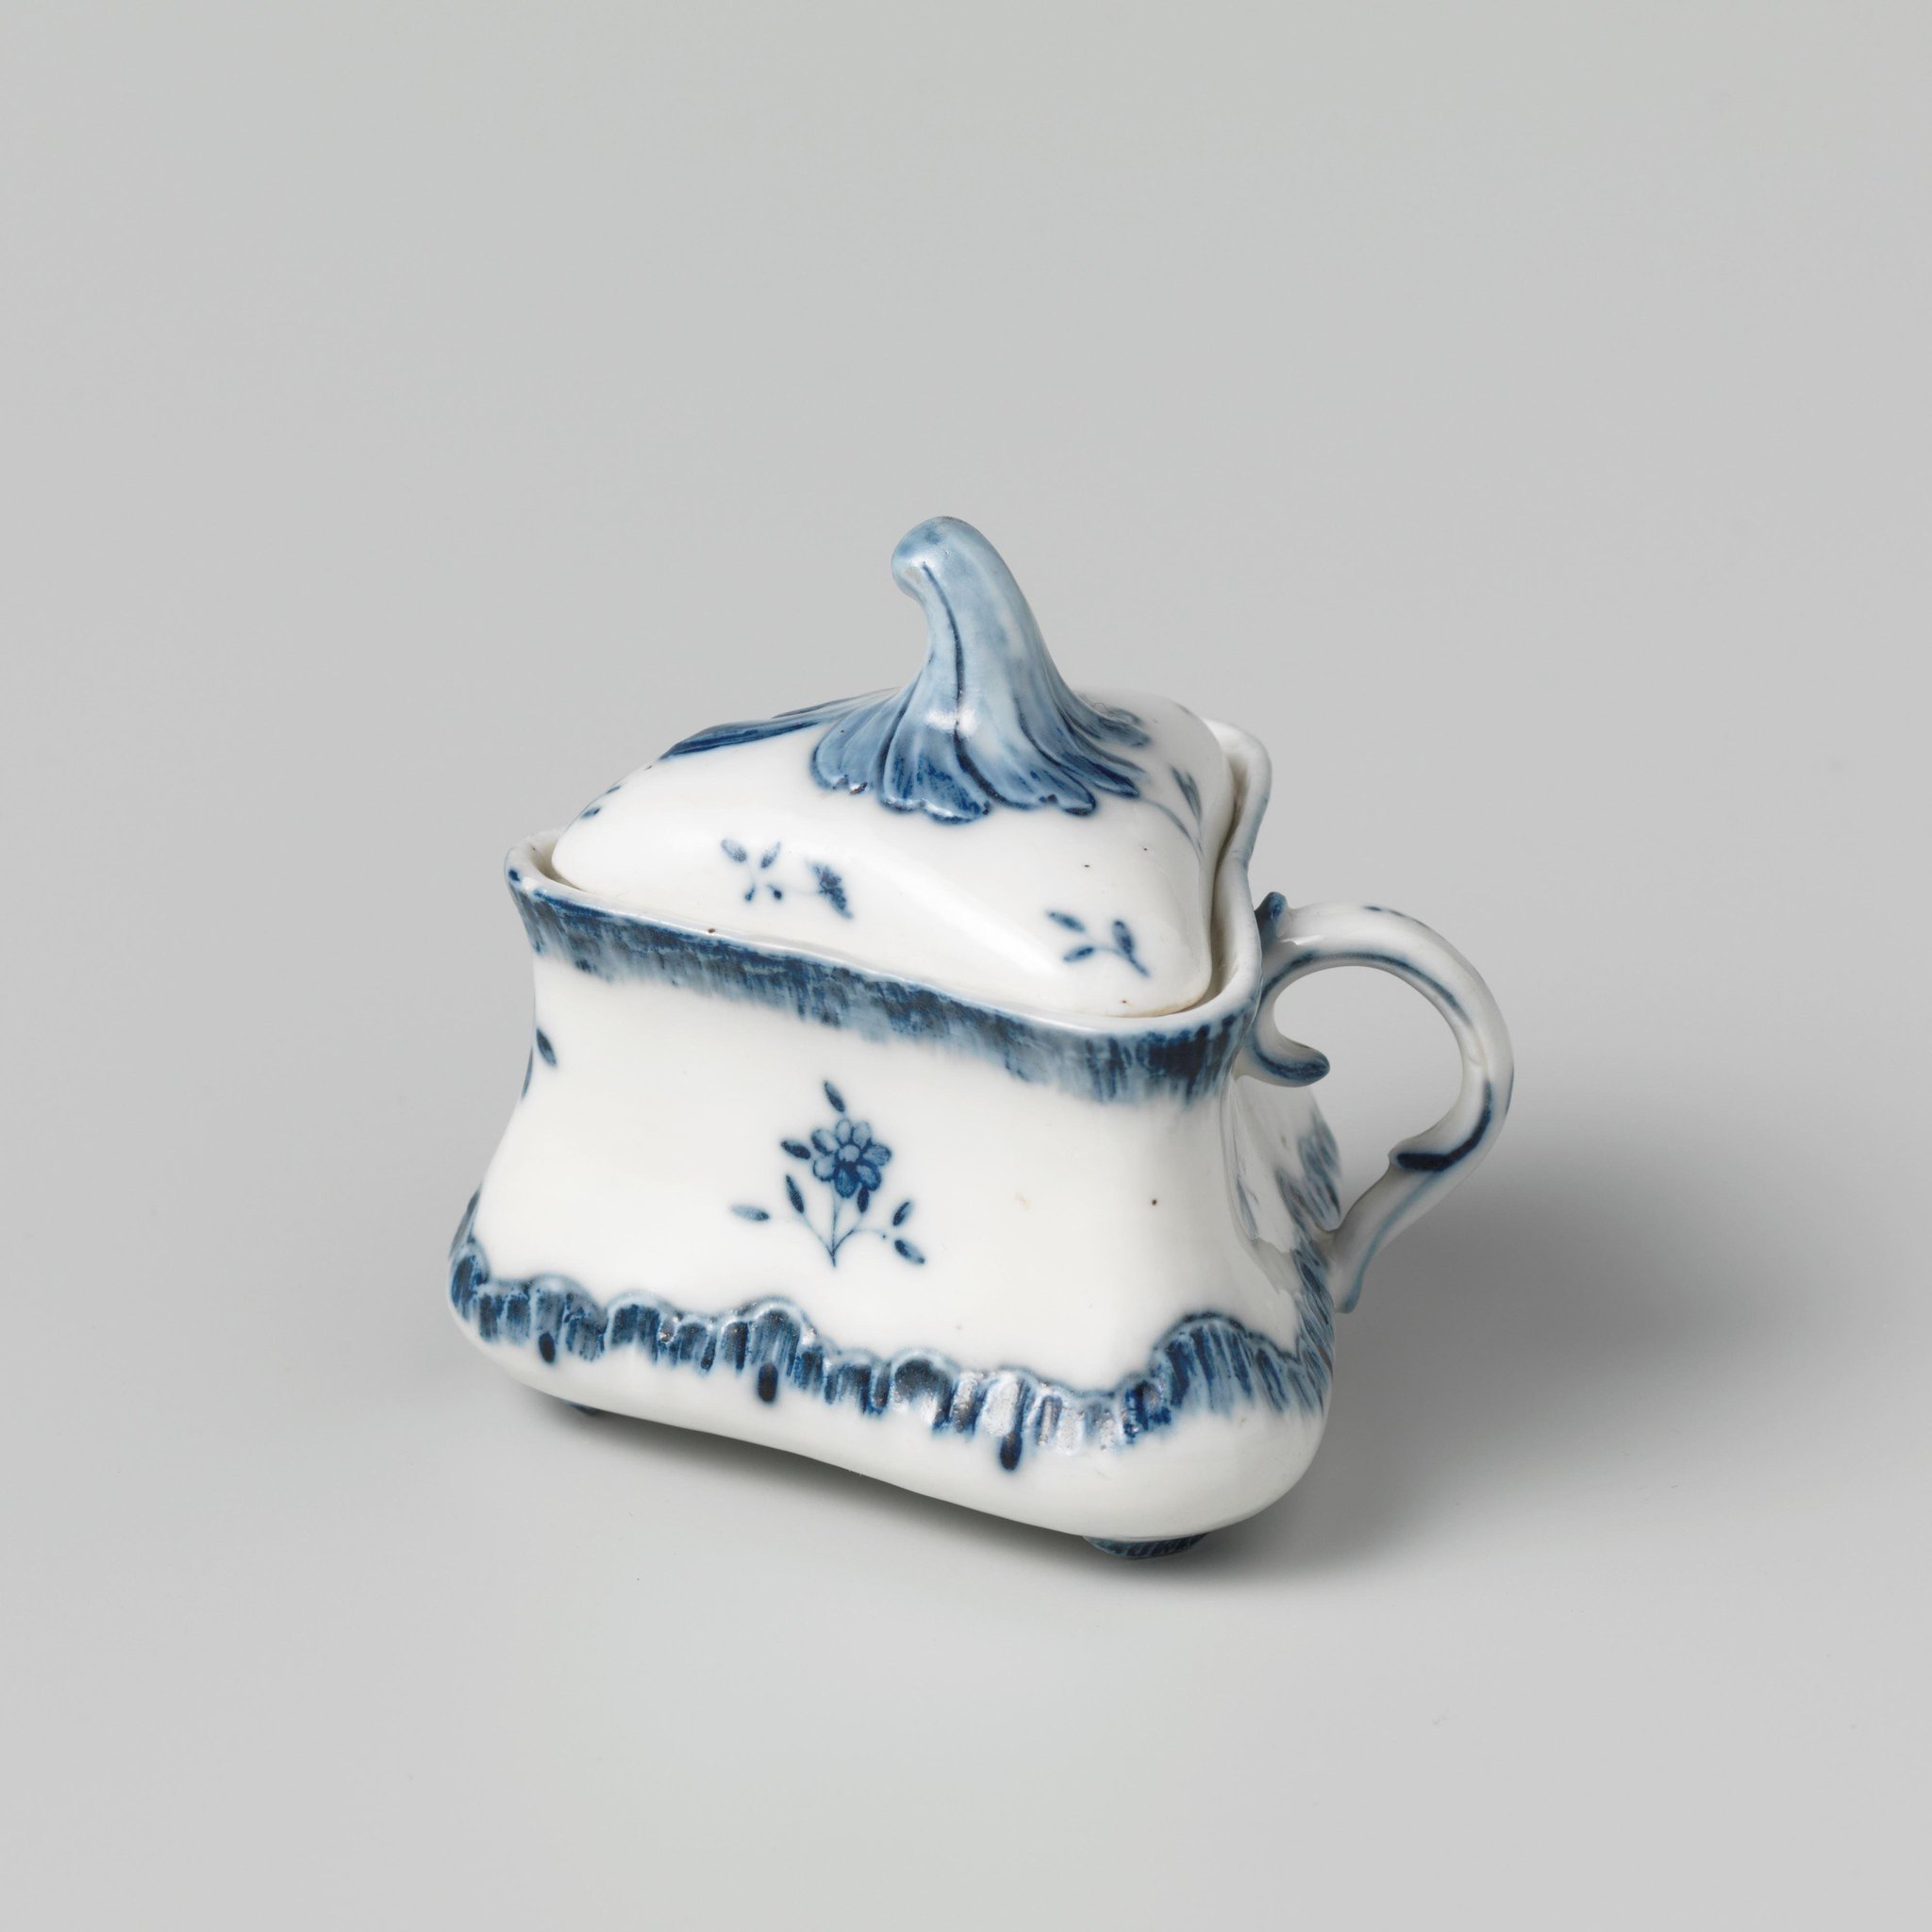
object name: roompot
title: Roompot, beschilderd met strooibloemen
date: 1774-1778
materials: porcelain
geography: loosdrecht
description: Roompot van porselein. Driehoekig met vraagtekenvormig oor en ingesnoerde wand. Langs mond- en voetrand rocaille-ornament in reliëf. Beschilderd in onderglazuurblauw met strooibloemen. De randen, beschilderd in dezelfde kleur.